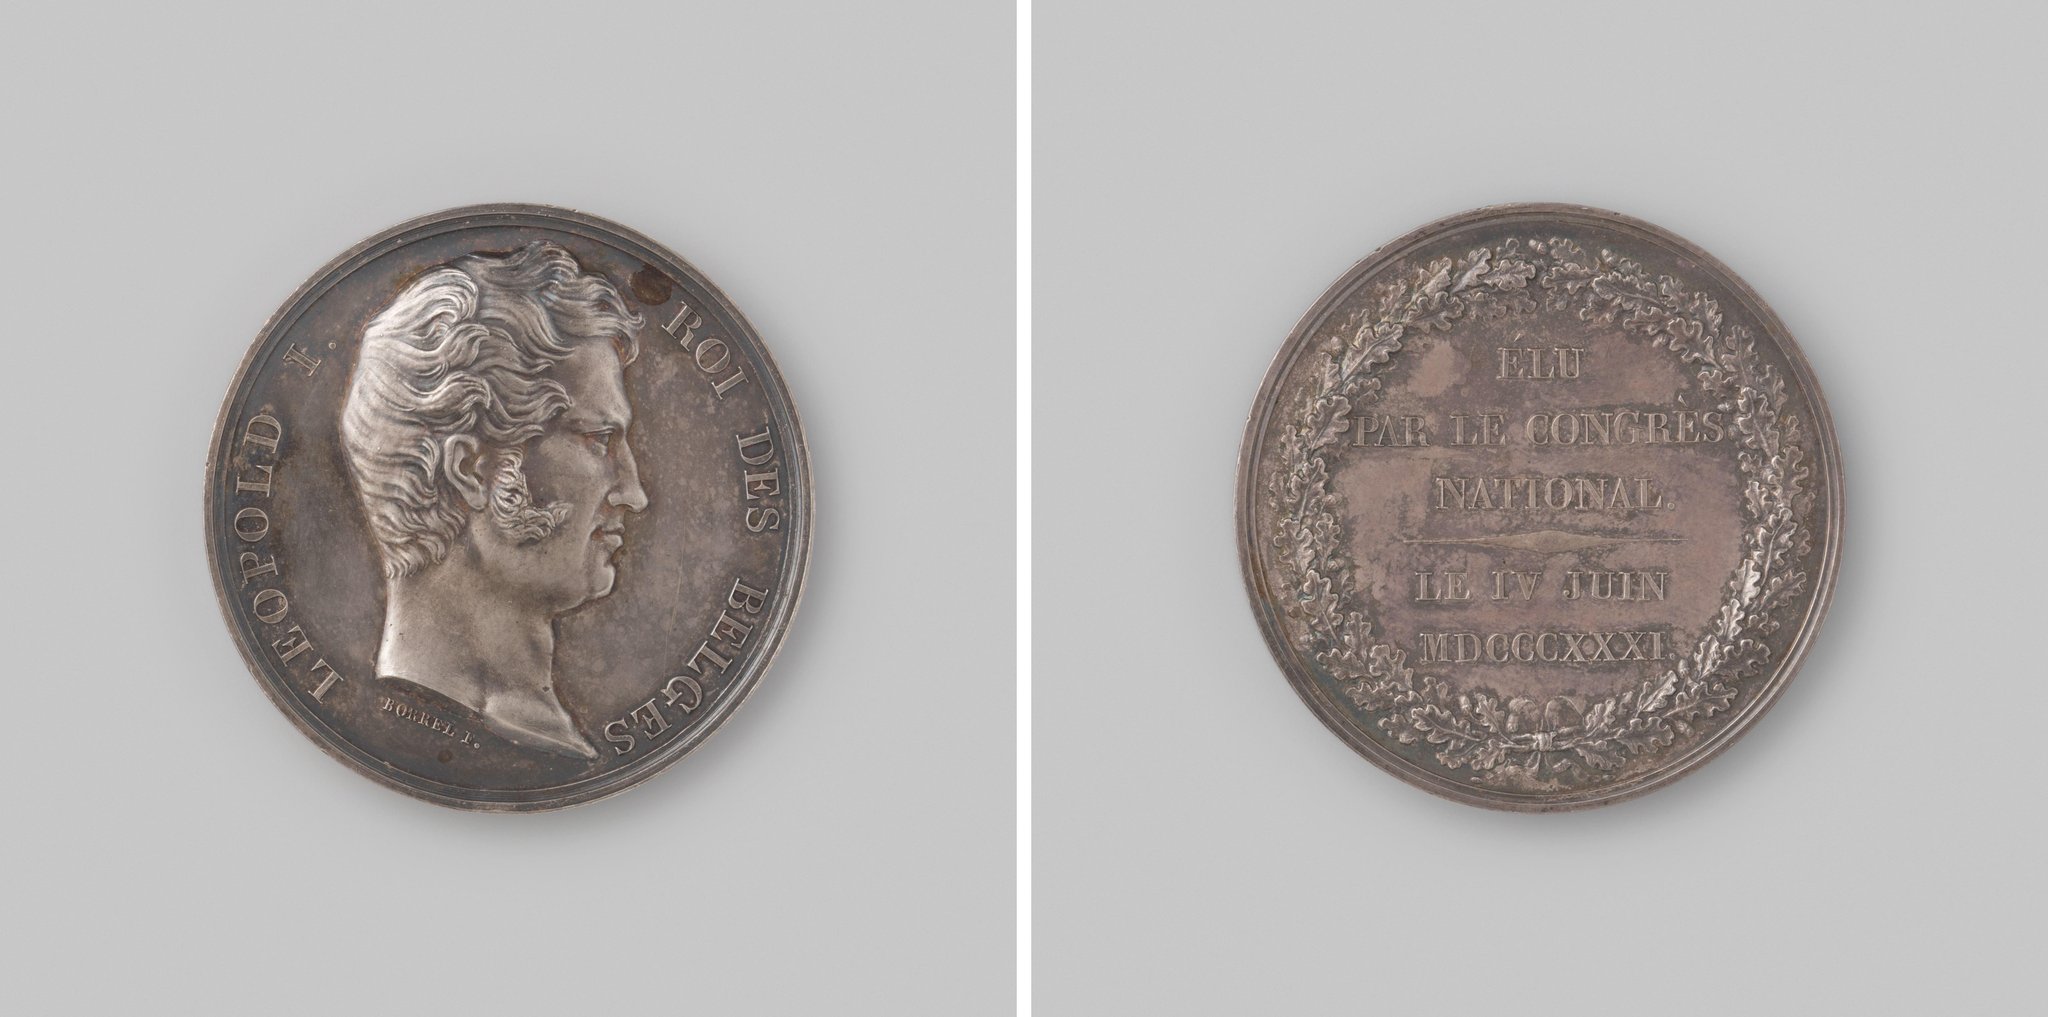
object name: history medal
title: Leopold van Saksen-Coburg door het Nationaal Congres verkozen tot koning van België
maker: m. borrel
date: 1831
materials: silver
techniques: striking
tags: laeken, leopold i (koning der belgen)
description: Zilveren penning. Voorzijde: borststuk man binnen omschrift. Keerzijde: opschrift binnen eikenkrans